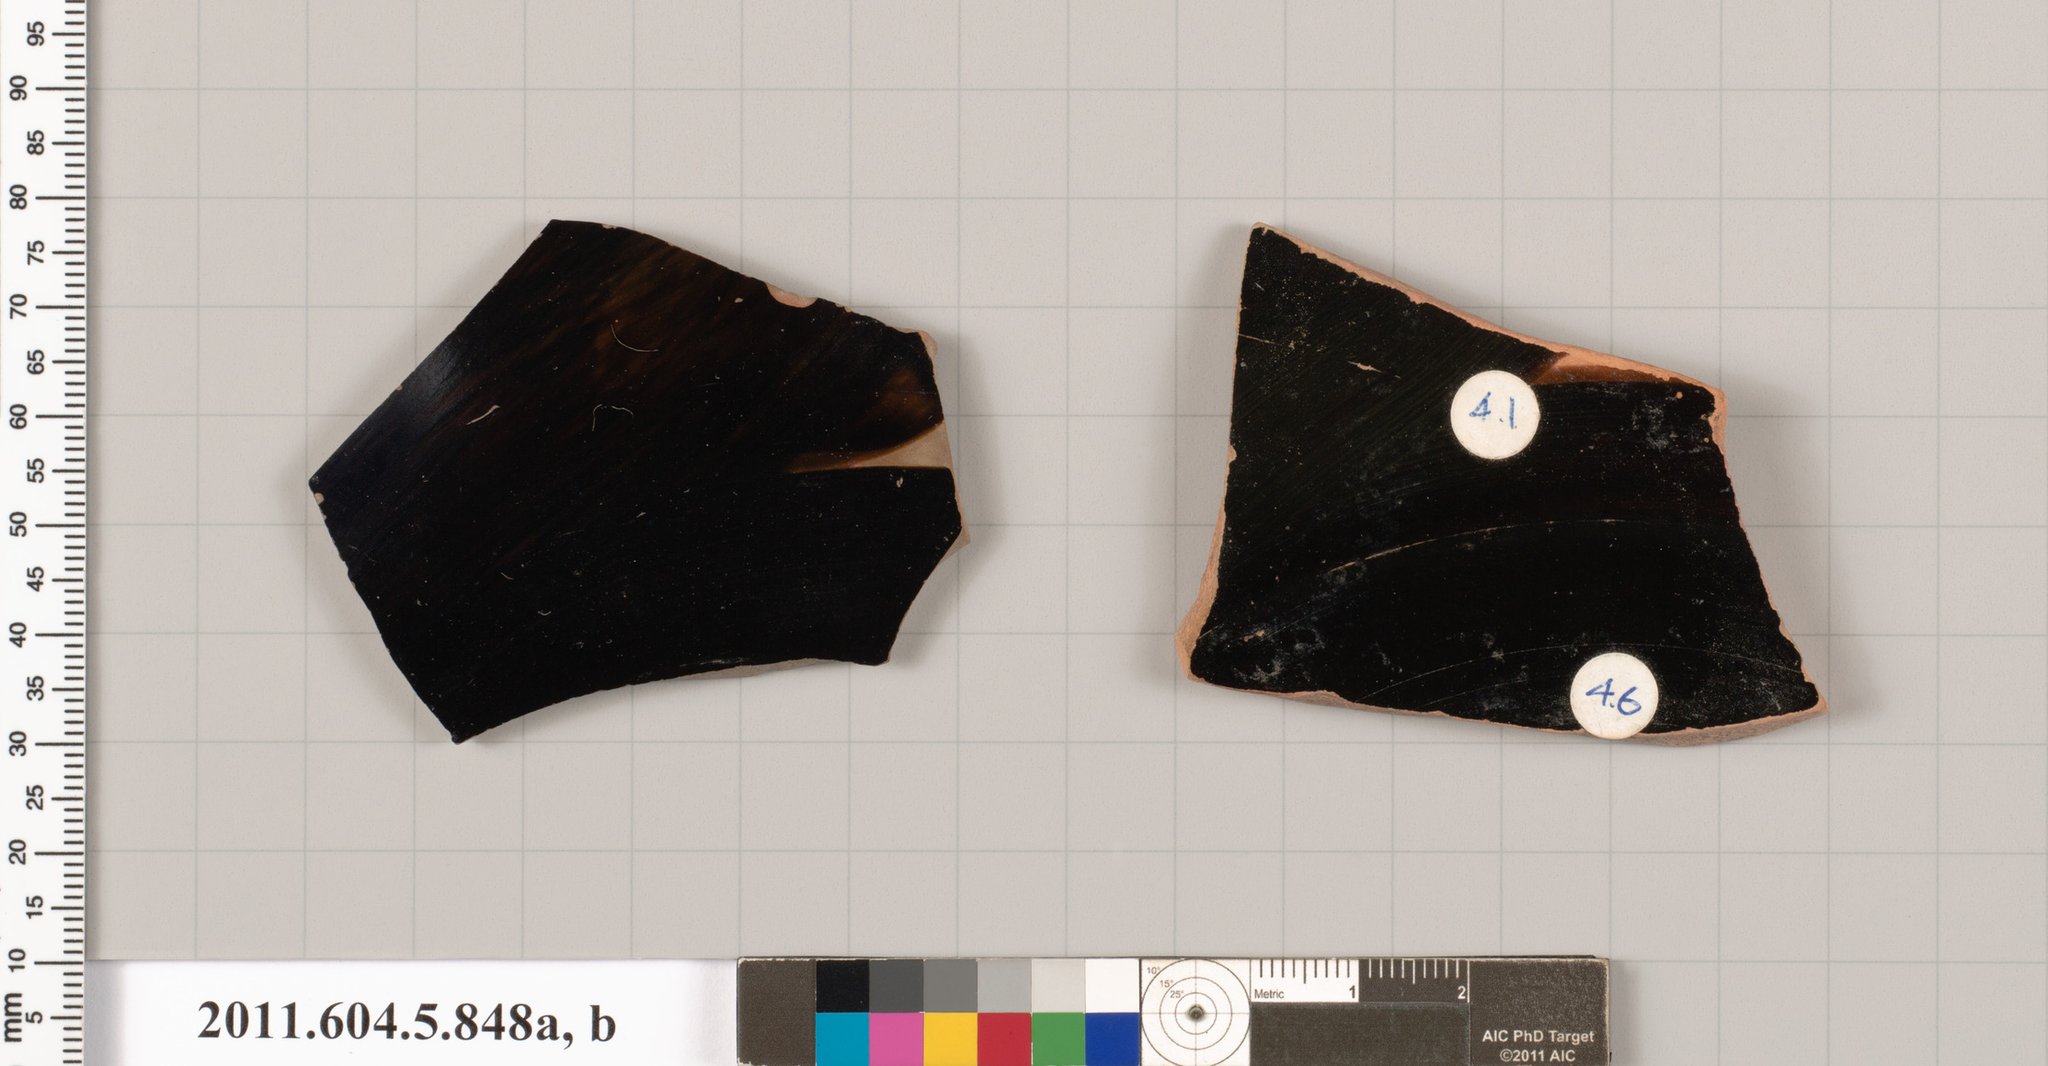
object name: kylix fragment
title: Terracotta fragments of kylikes (drinking cups)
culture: greek, attic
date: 600-401 BCE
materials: terracotta